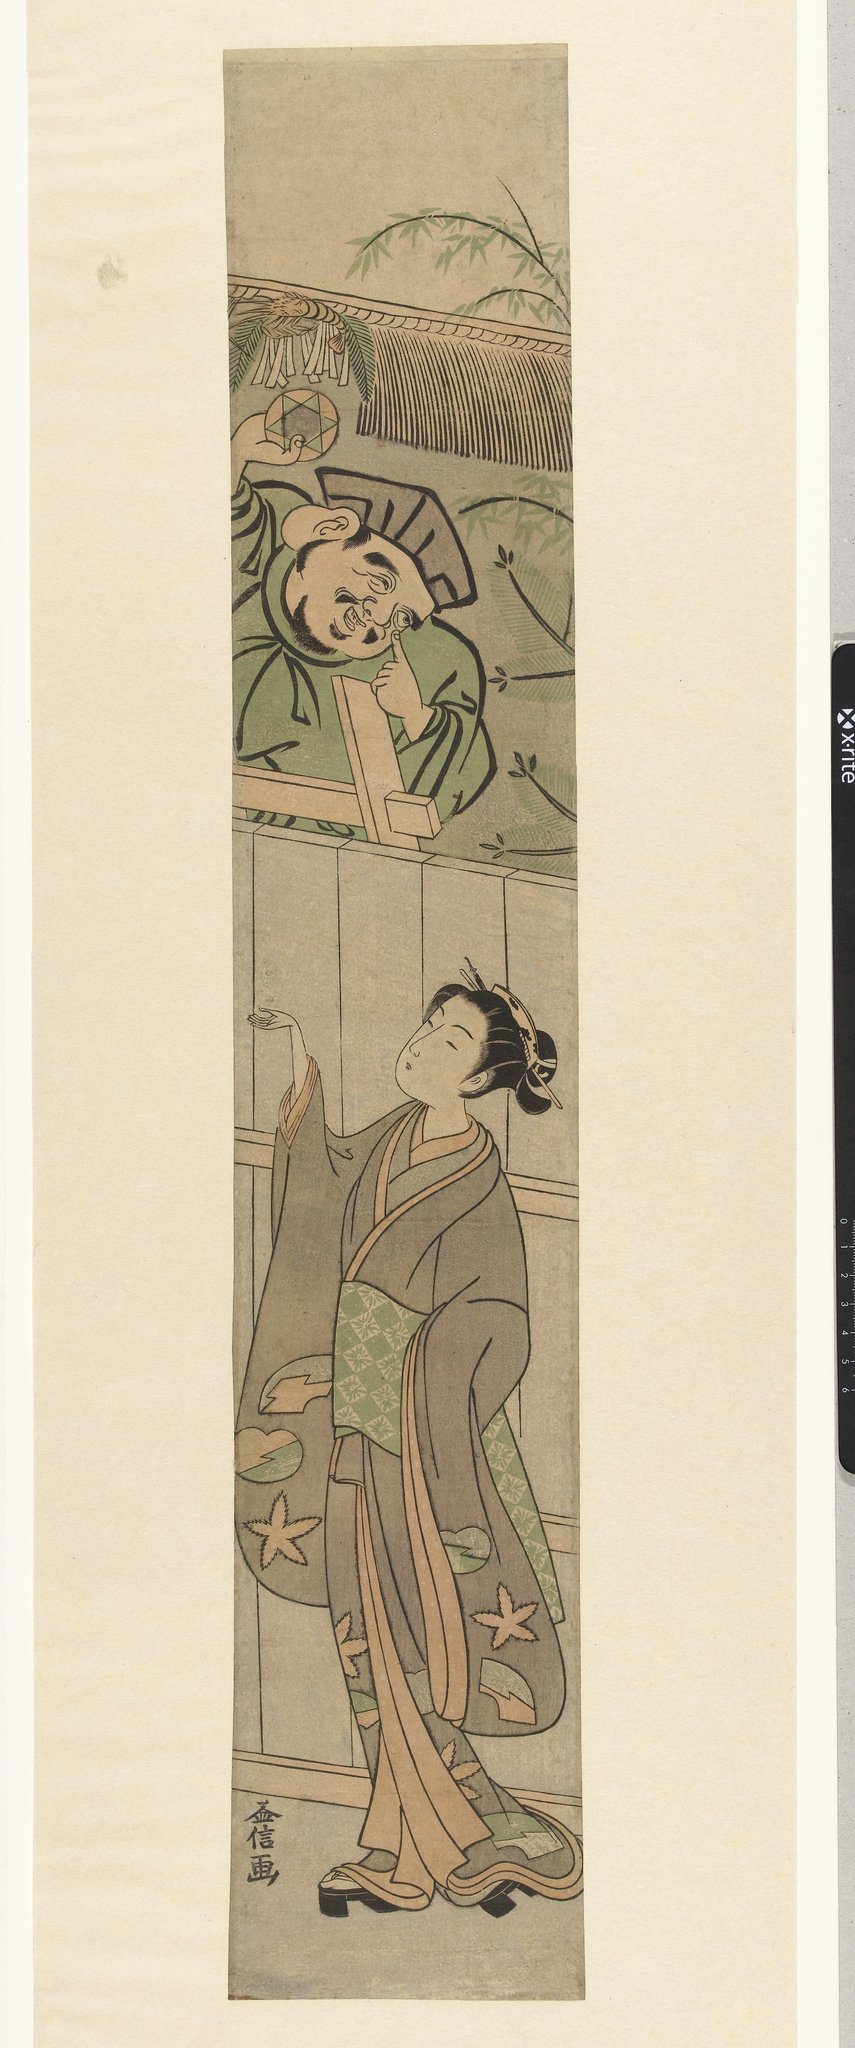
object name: print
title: Ebisu geeft meisje haar bal terug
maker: masunobu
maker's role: print maker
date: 1770-1775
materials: paper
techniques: woodcut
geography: japan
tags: fence, wall, paling, ball games, representations ~ gods, demi-gods, heroes, etc. (hinduism, buddhism, jainism)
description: Meisje, staand bij schutting, haar hand ophoudend voor de bal die de geluksgod Ebisu, staand op ladder, voor haar uit de tuin heeft gehaald. De decoratie boven Ebisu, een touw waaraan dennentakken en langoustine zijn bevestigd, duidt op Nieuwjaar.